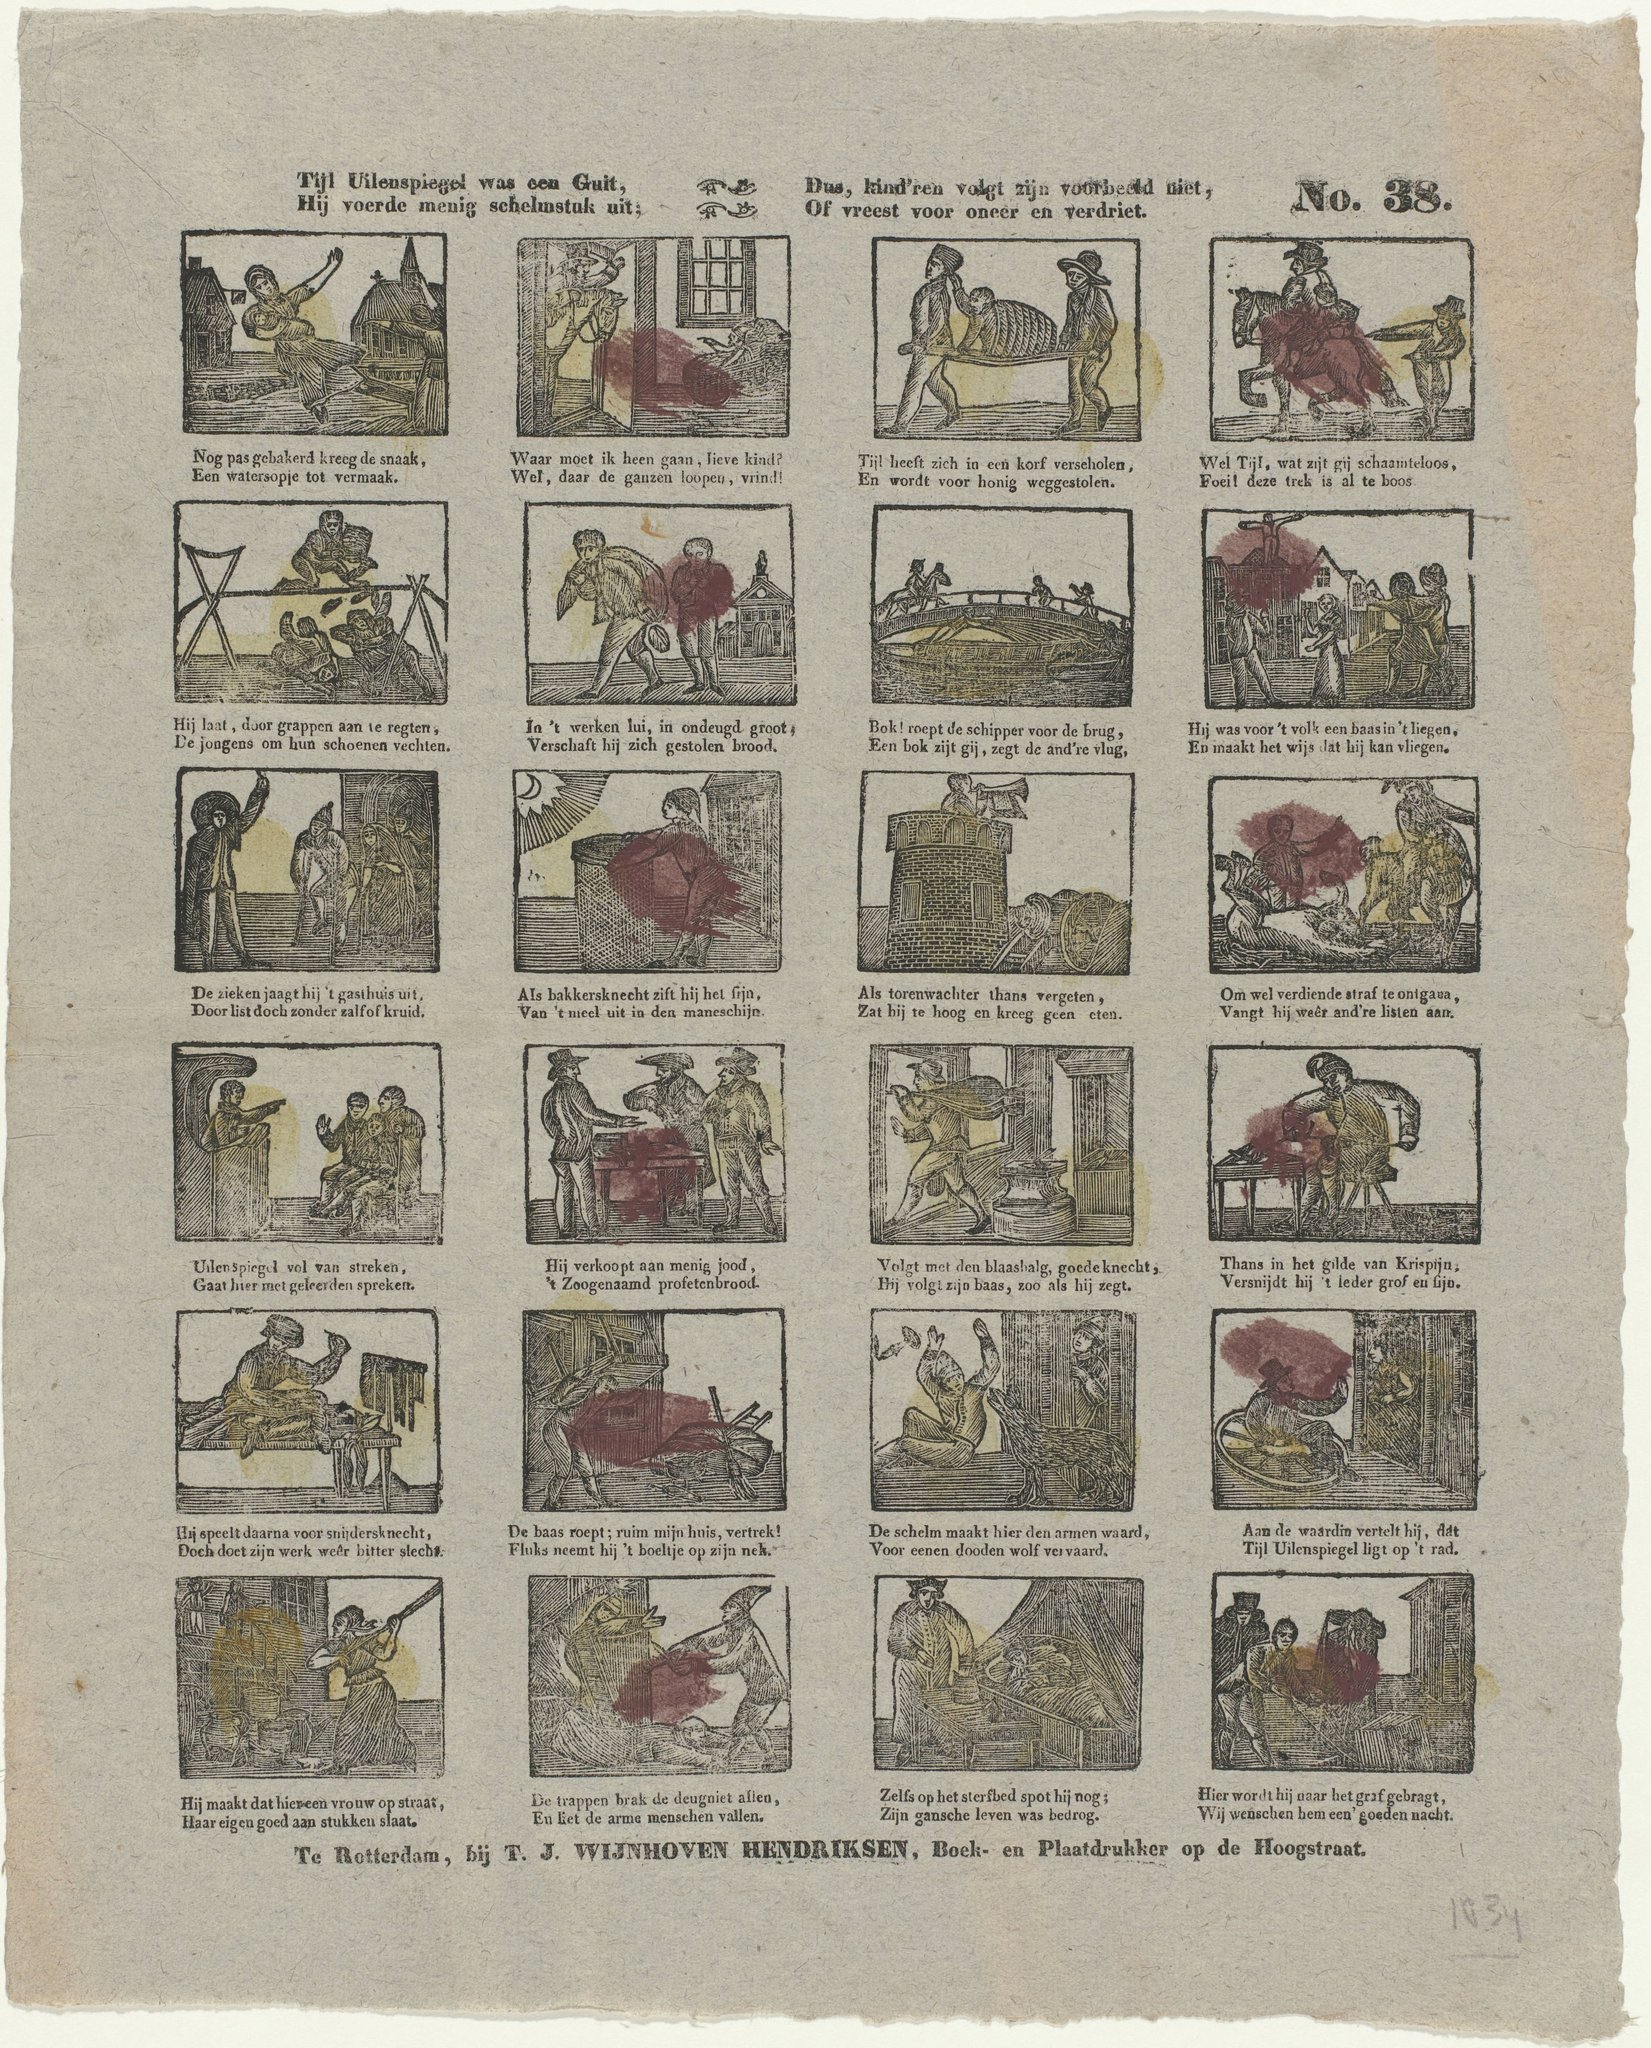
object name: print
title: Tijl Uilenspiegel was een guit, / Hij voerde menig schelmstuk uit; / Dus, kind'ren volgt zijn voorbeeld niet, / Of vreest voor oneer en verdriet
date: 1832-1850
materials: paper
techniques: colour, letterpress printing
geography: rotterdam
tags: eulenspiegel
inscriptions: collector's mark: Lugt 2760, collector's mark: Lugt 2228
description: Blad met 24 voorstellingen over het leven van Tijl Uilenspiegel. Onder elke afbeelding een tweeregelig vers. Genummerd rechtsboven: No. 38.